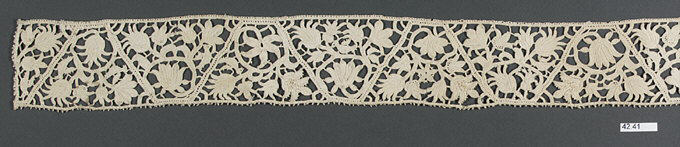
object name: border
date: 1601-1700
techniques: lace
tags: flowers